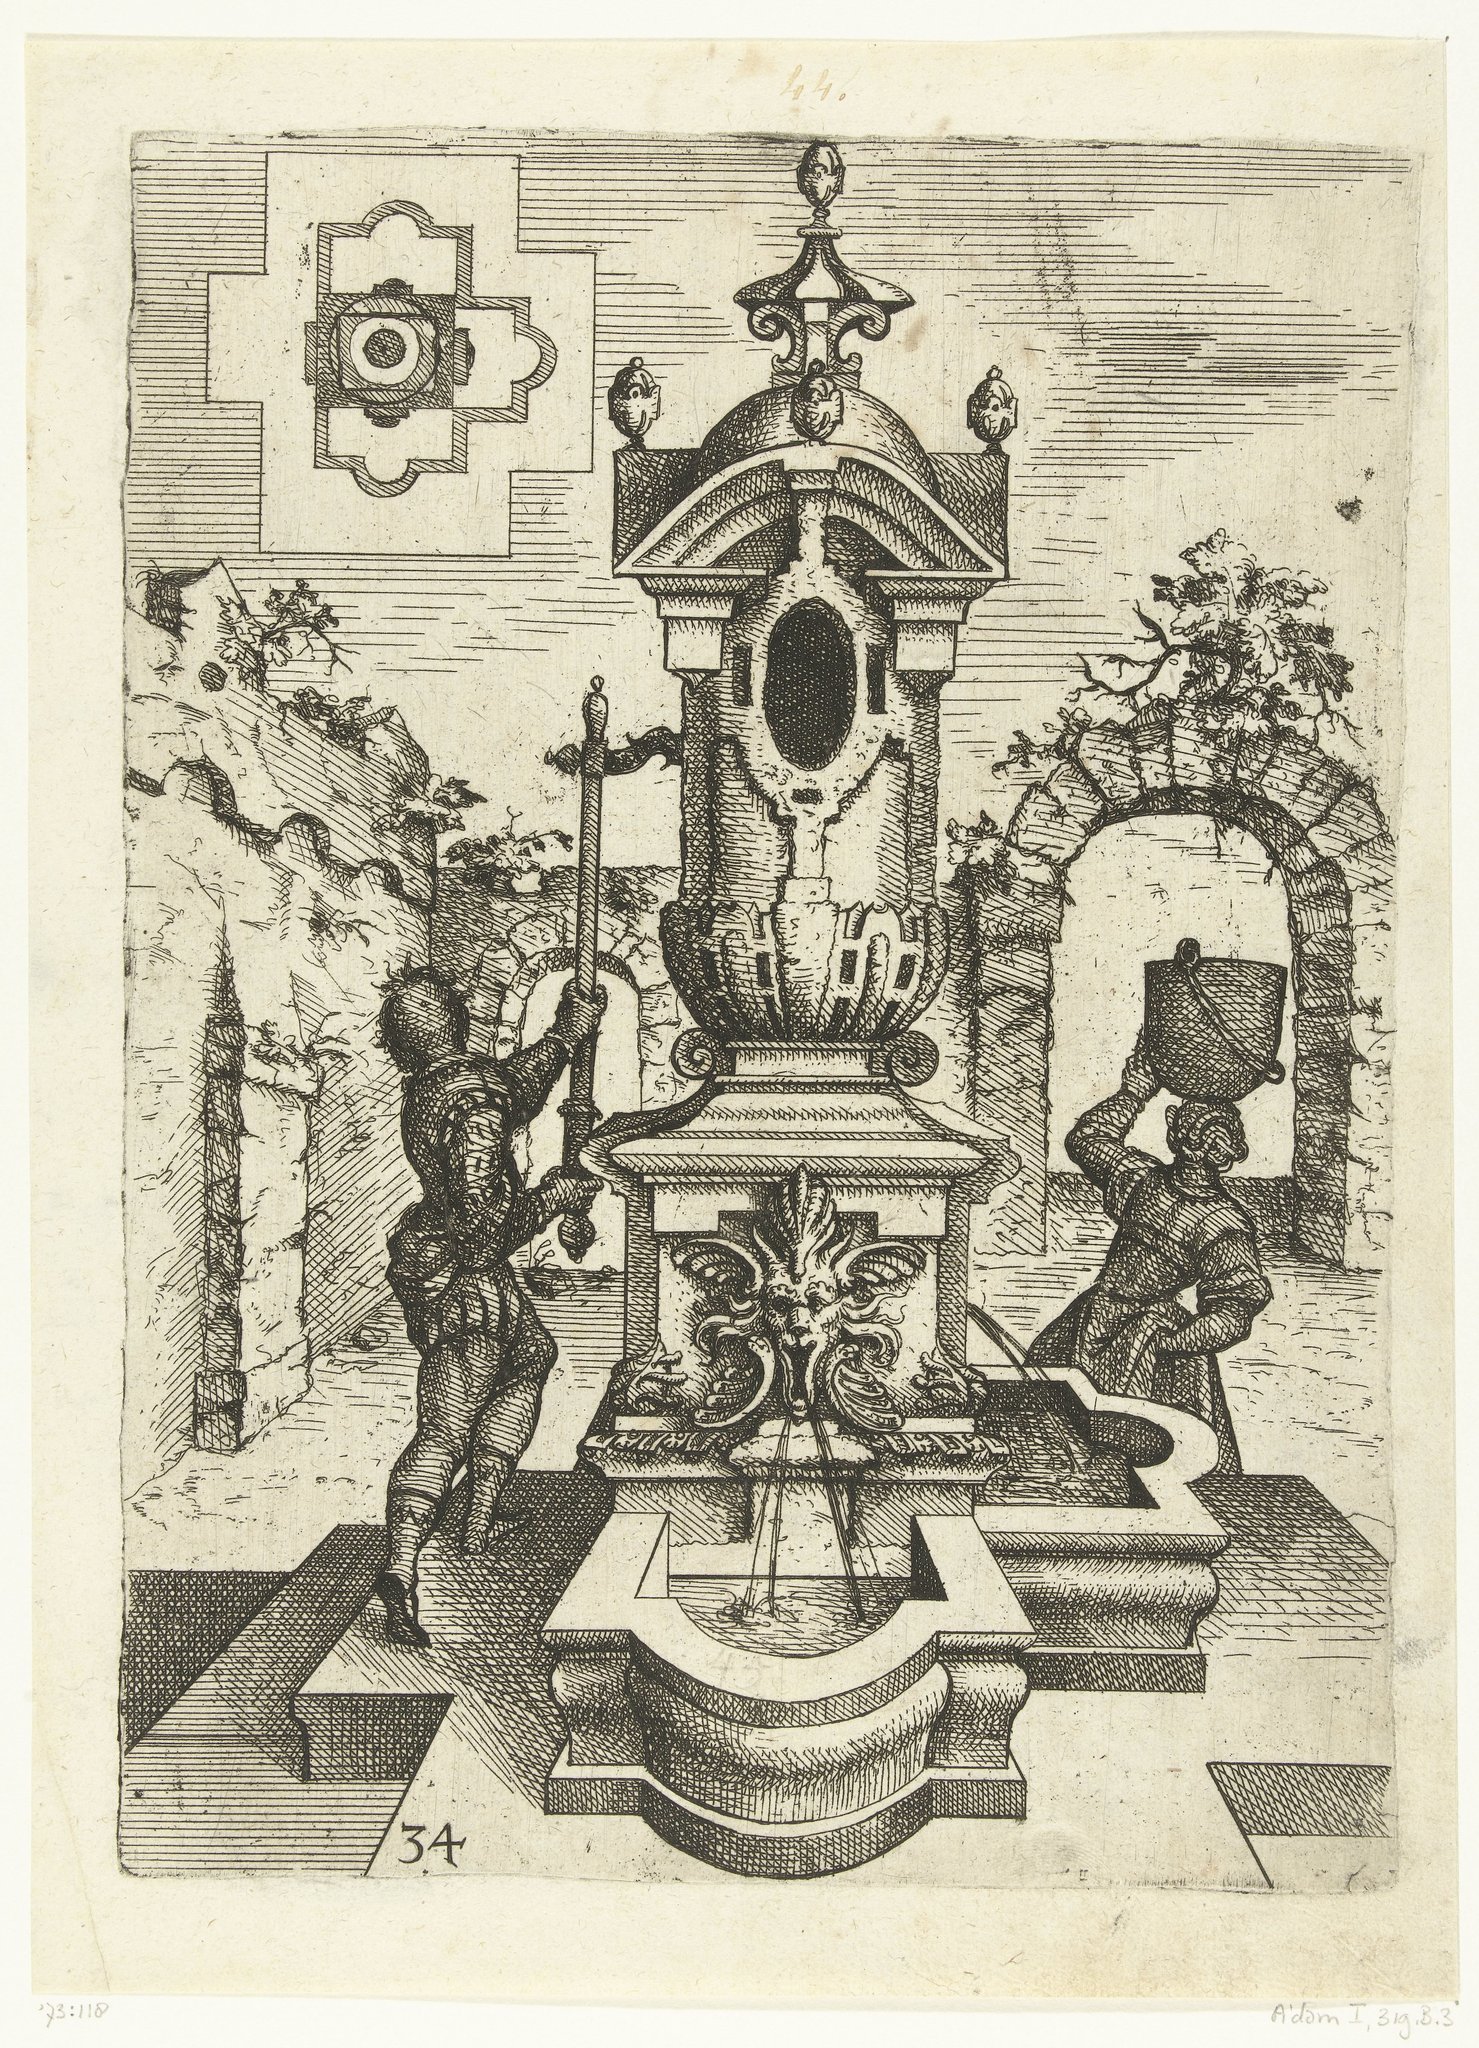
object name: ornament print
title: Titelblad en 11 bladen van "Architectura und Aufstheilung der V Senln (...)" 1593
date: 1560-1598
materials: paper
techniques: etching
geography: germany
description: Links bedient een man de zwengel, rechts loopt een vrouw weg met een watervat op haar hoofd. Linksboven is de plattegrond van de pomp getekend. Eén van 20 bladen uit een serie (Architectura. Von Ausztheilung, Symmetria und Proportion der fünff Seulen...) bestaande uit 193 bladen en 5 titelbladen, verdeeld over vijf boeken. Het gaat hier om een tweede, uitgebreide editie van de onder Orn Cat I-319 beschreven serie.